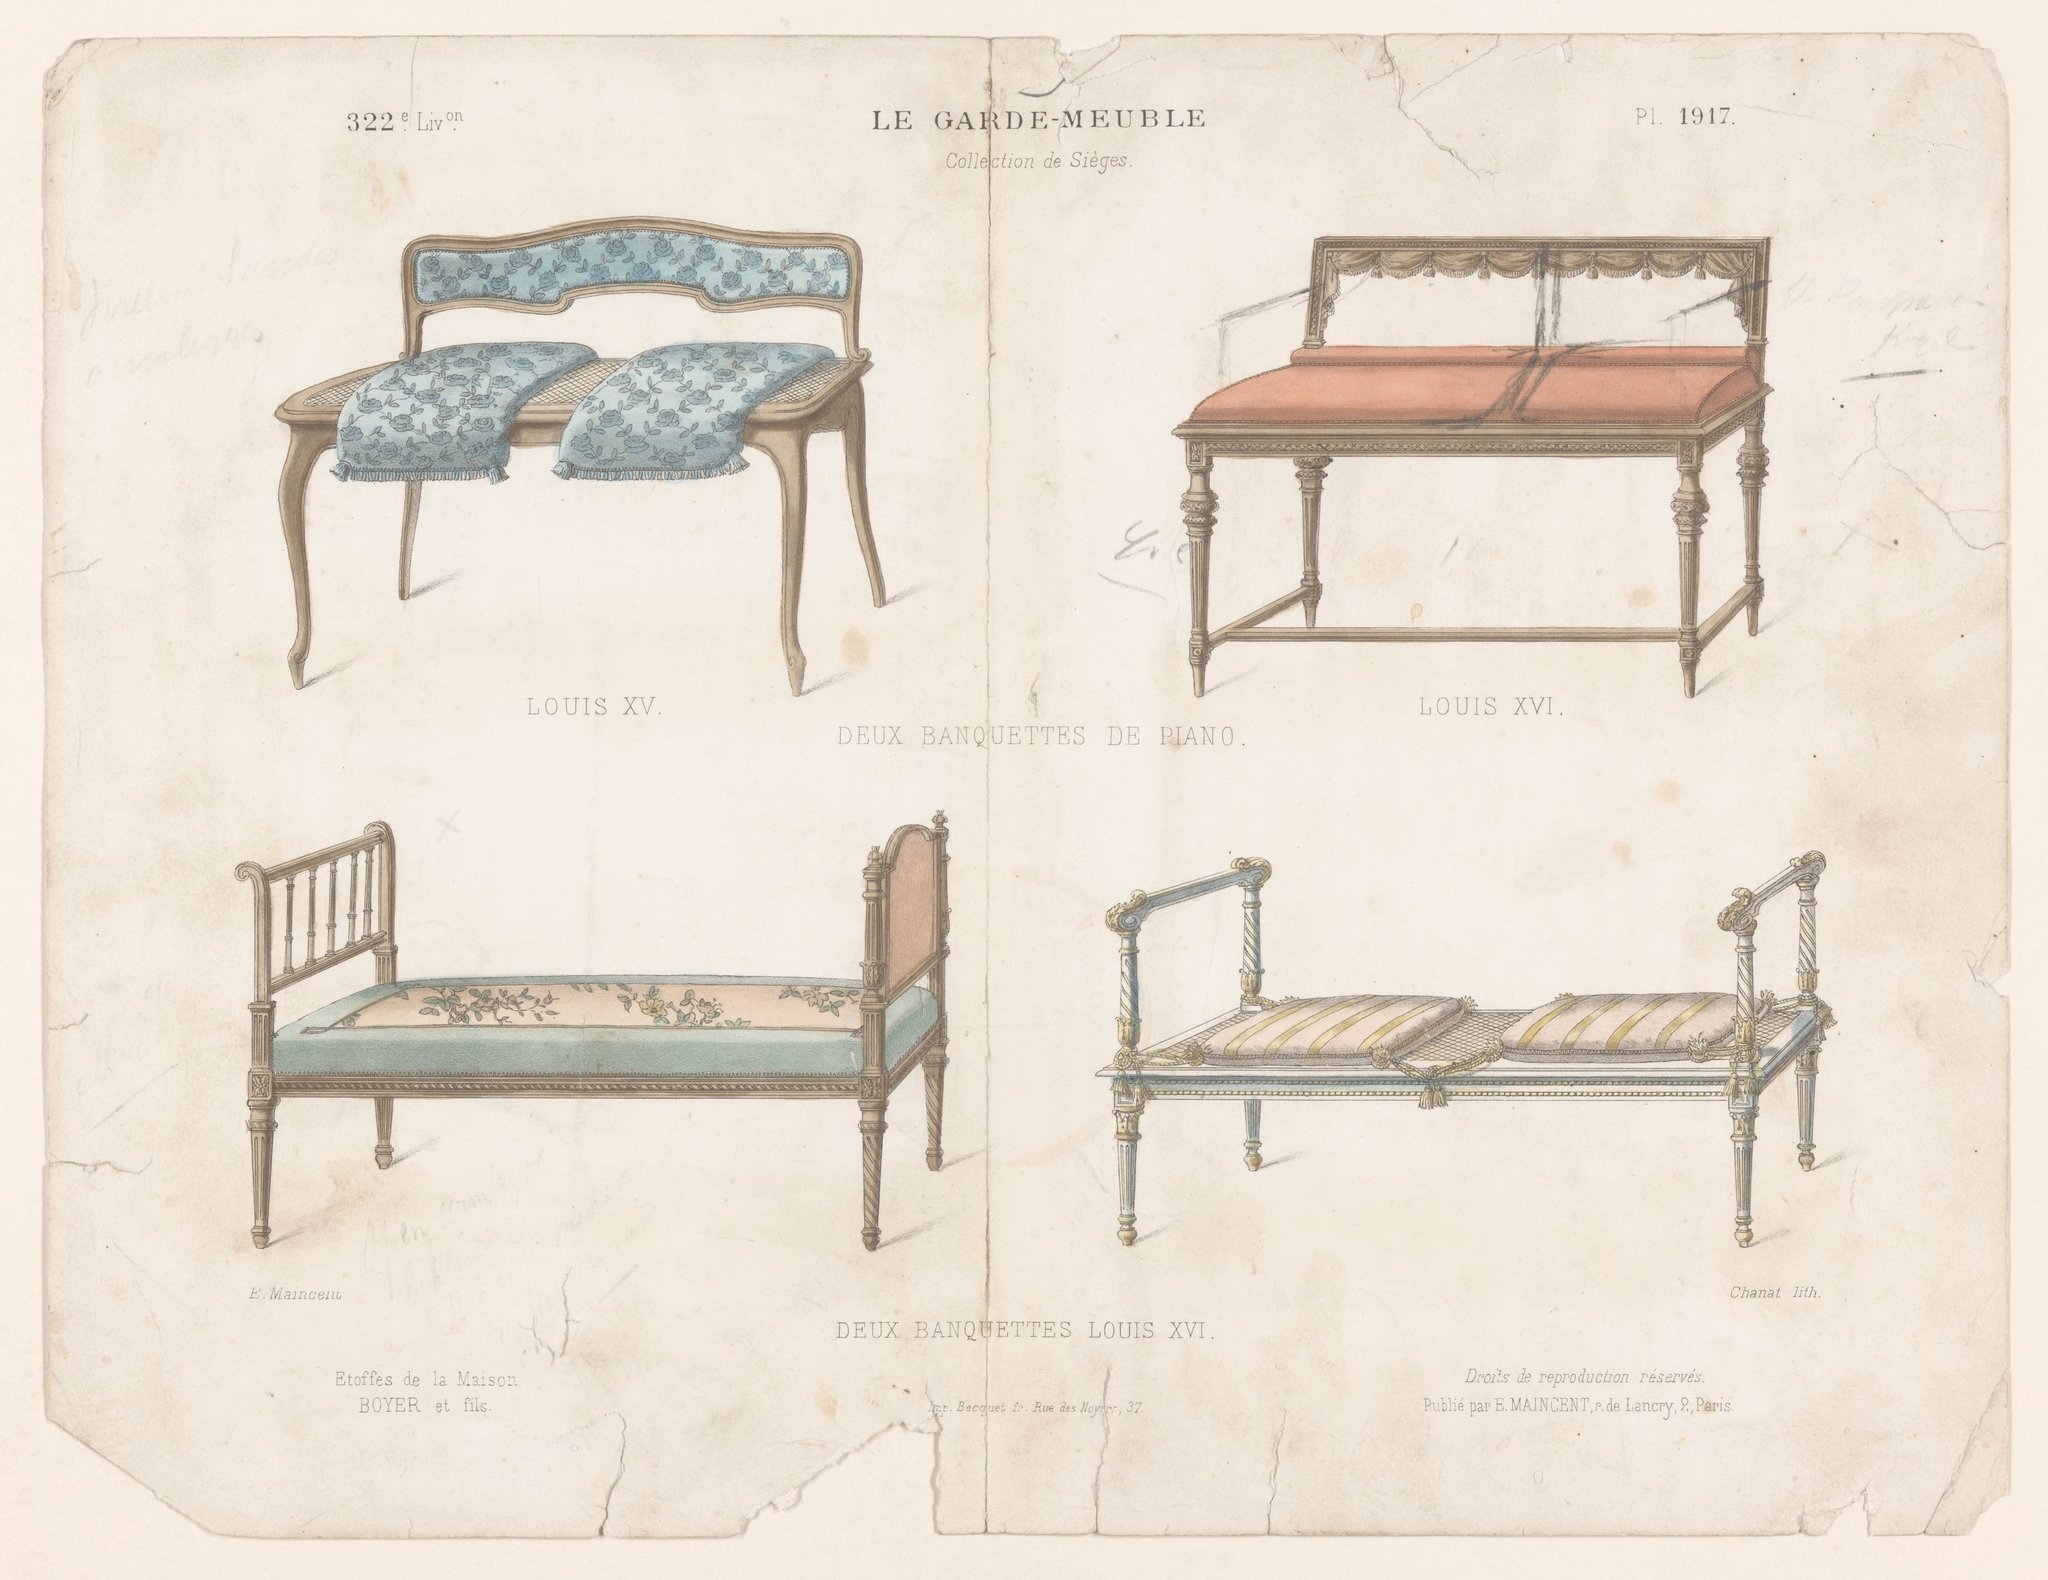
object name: print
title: Le garde-meuble / Collection de Sièges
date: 1885-1895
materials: paper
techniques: hand coloring, lithograph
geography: paris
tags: seating furniture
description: Ieder Livraison in de serie Le Garde-Meuble bevat negen platen: drie 'sièges' (zitmeubels), drie 'meubles' (diverse meubels zoals tafels en kasten) en drie 'tentures' (gordijnen en draperieën).